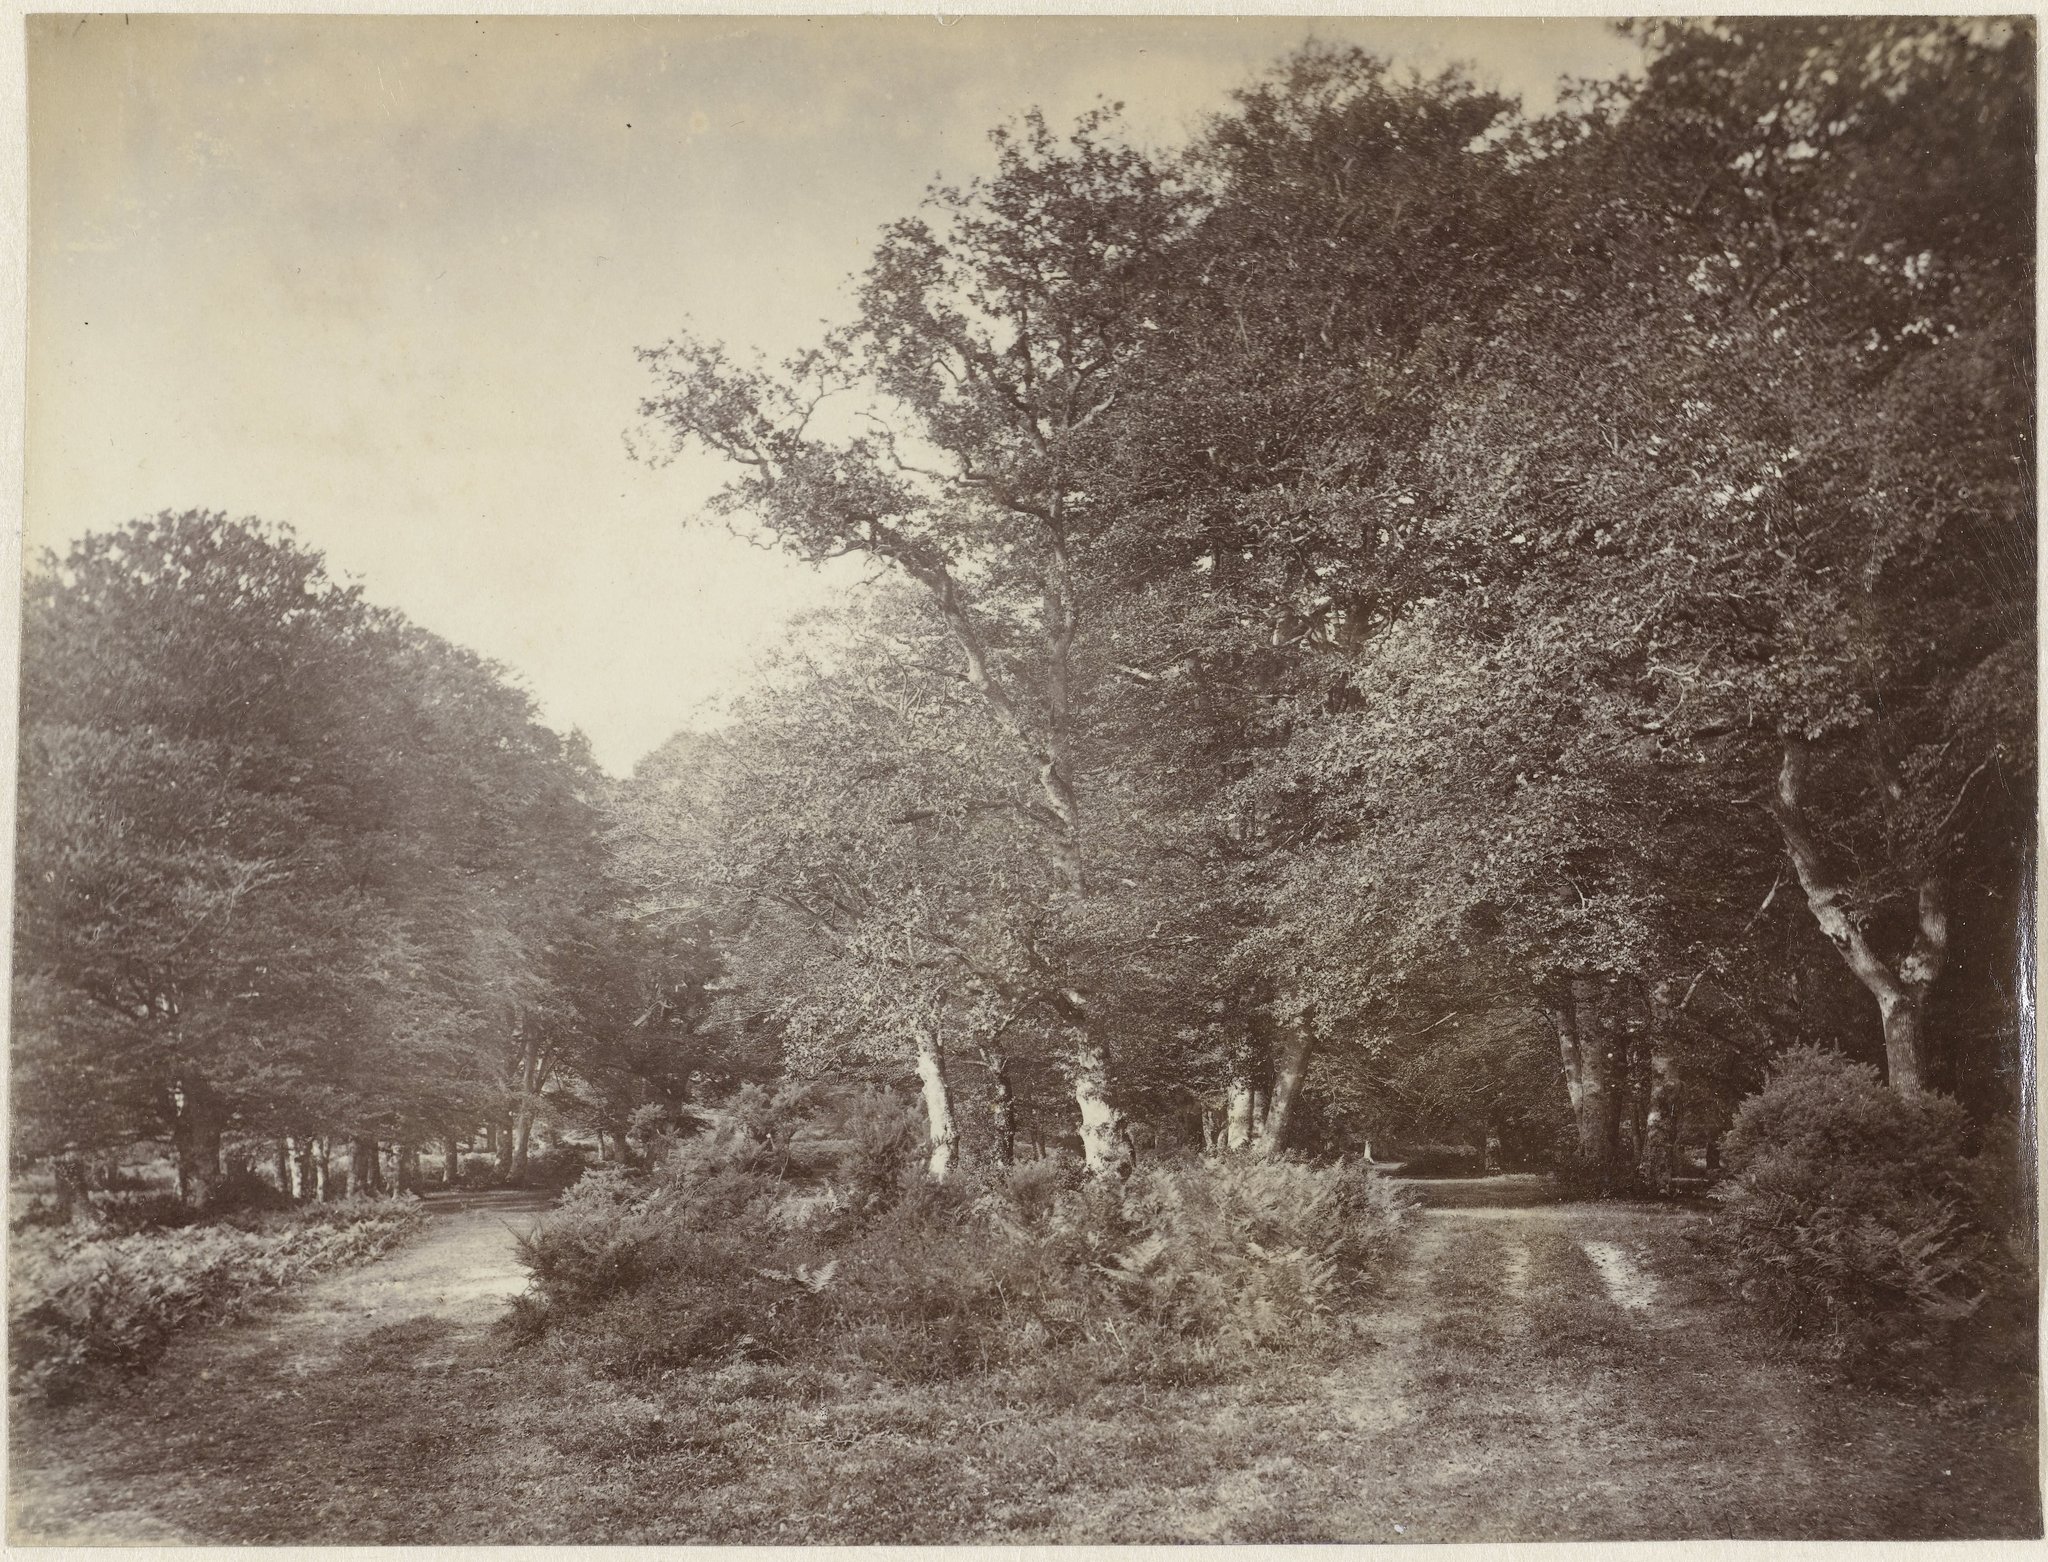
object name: photograph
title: Boslandschap in Groot-Brittannië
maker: john golden short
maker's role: fotograaf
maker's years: 1830-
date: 1855-1890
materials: paper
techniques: albumen print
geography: great britain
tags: forest, wood, great britain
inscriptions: inscription: ‘Double Sta[...] [onleesbaar]’